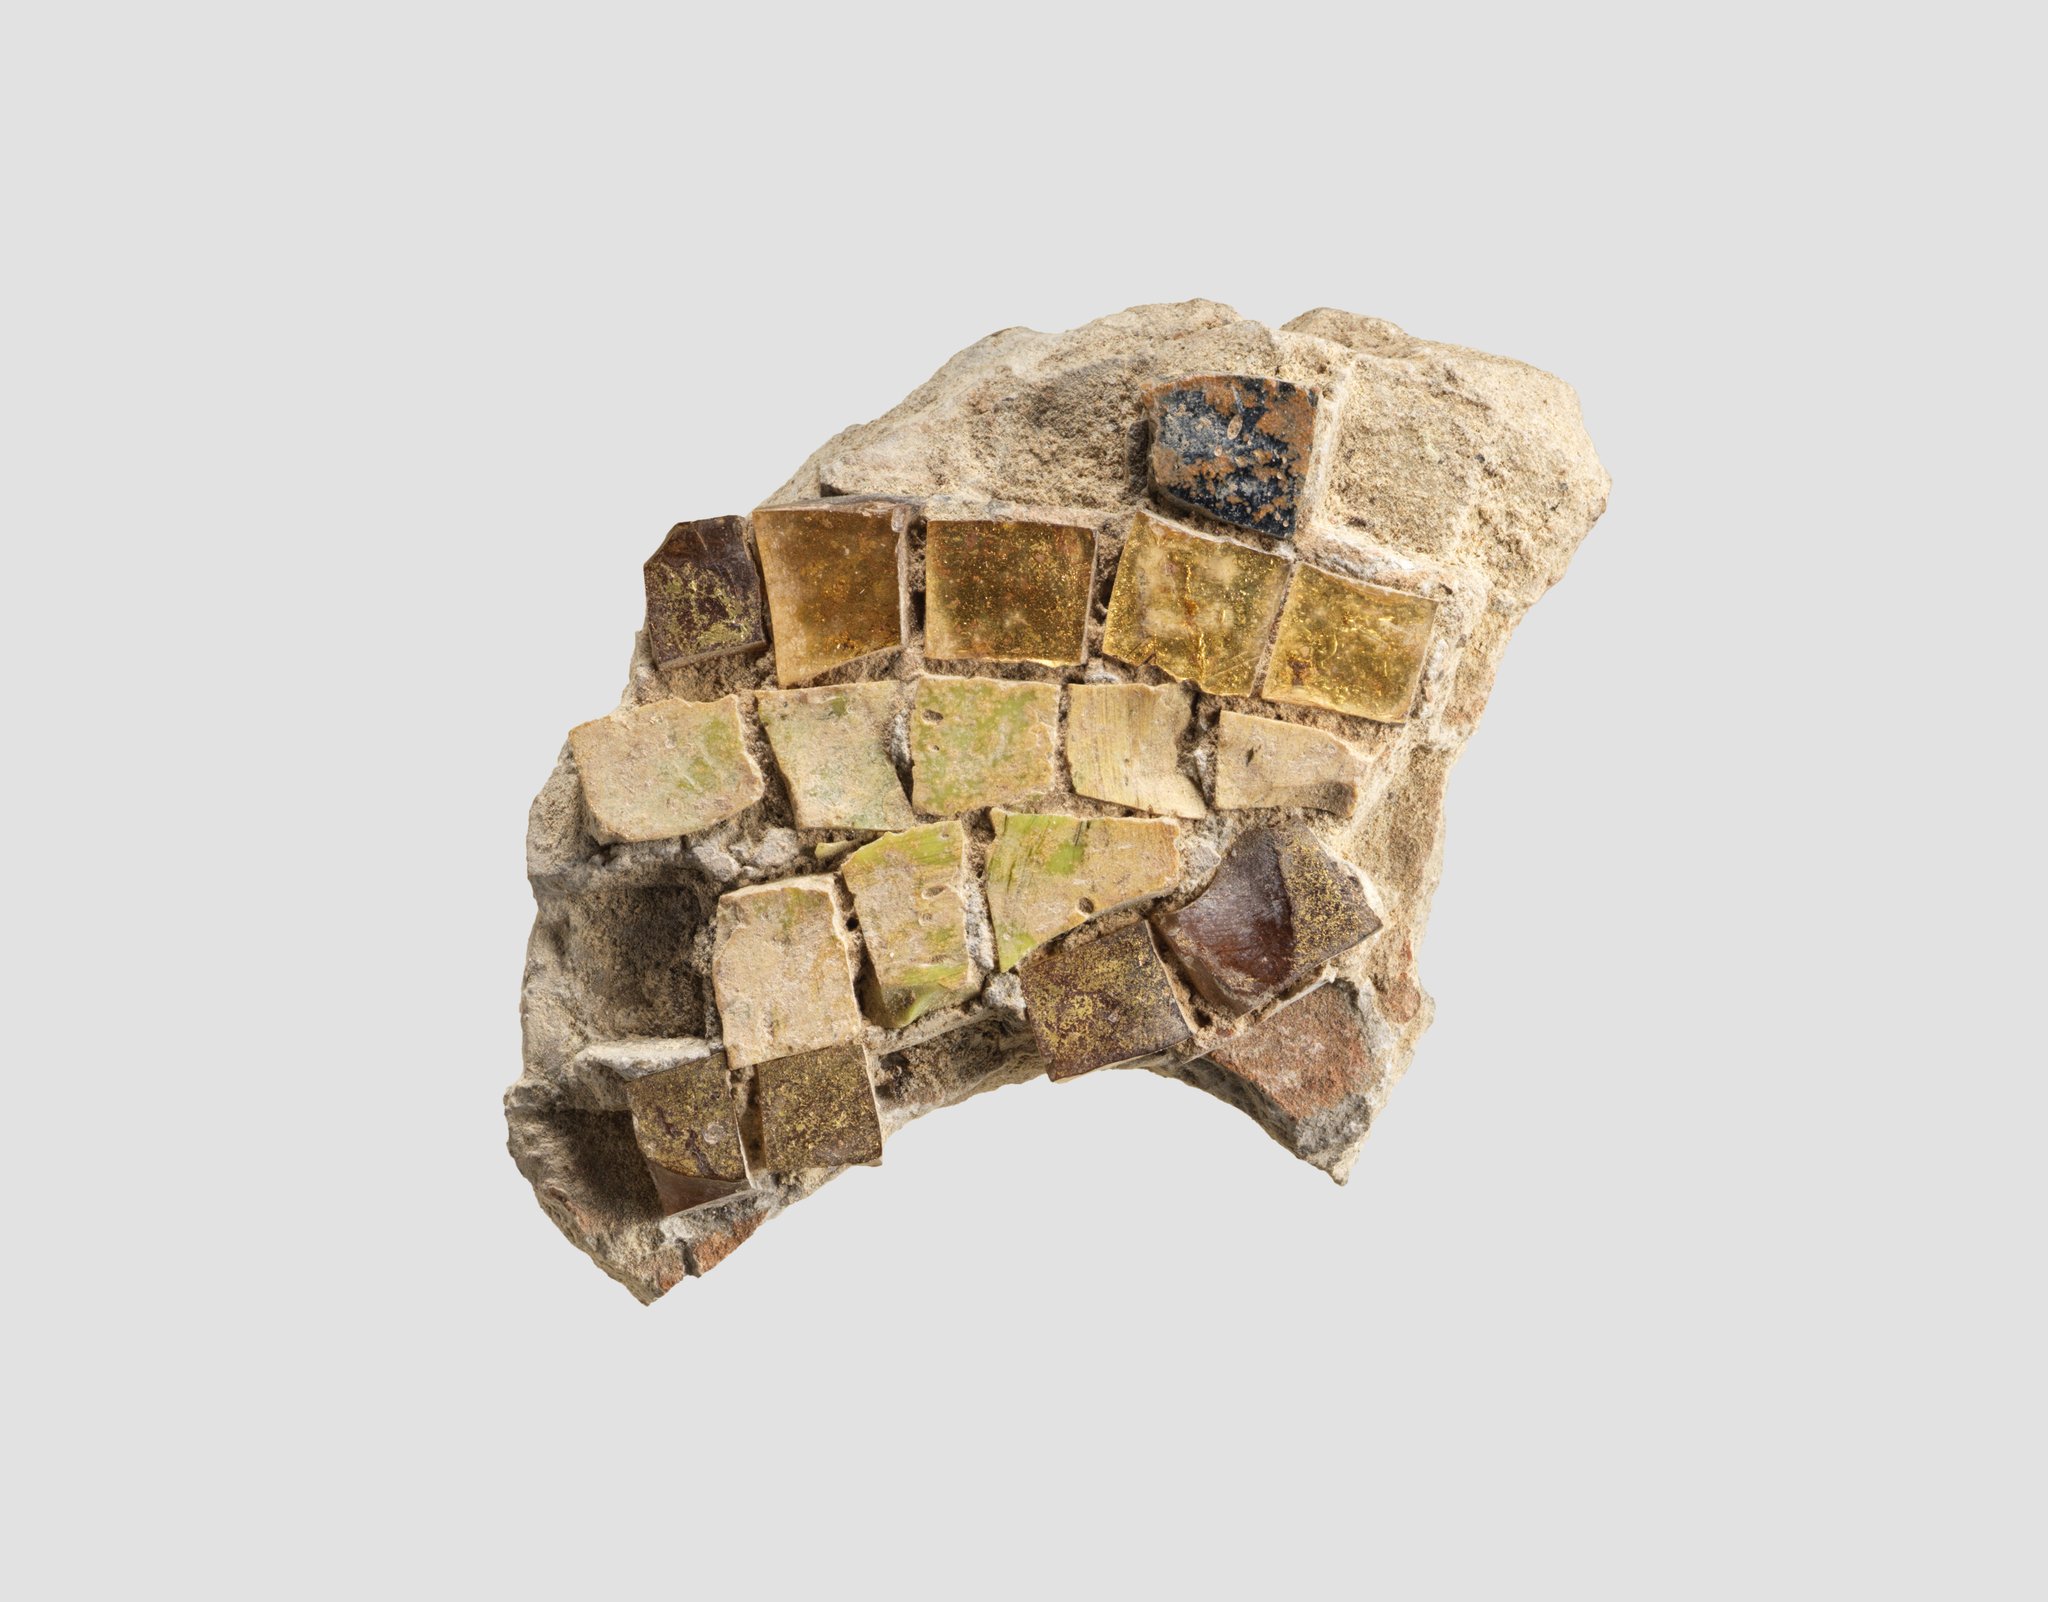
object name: mosaic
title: Mosaic fragment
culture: sasanian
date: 201-700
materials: glass, plaster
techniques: gilding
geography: mesopotamia